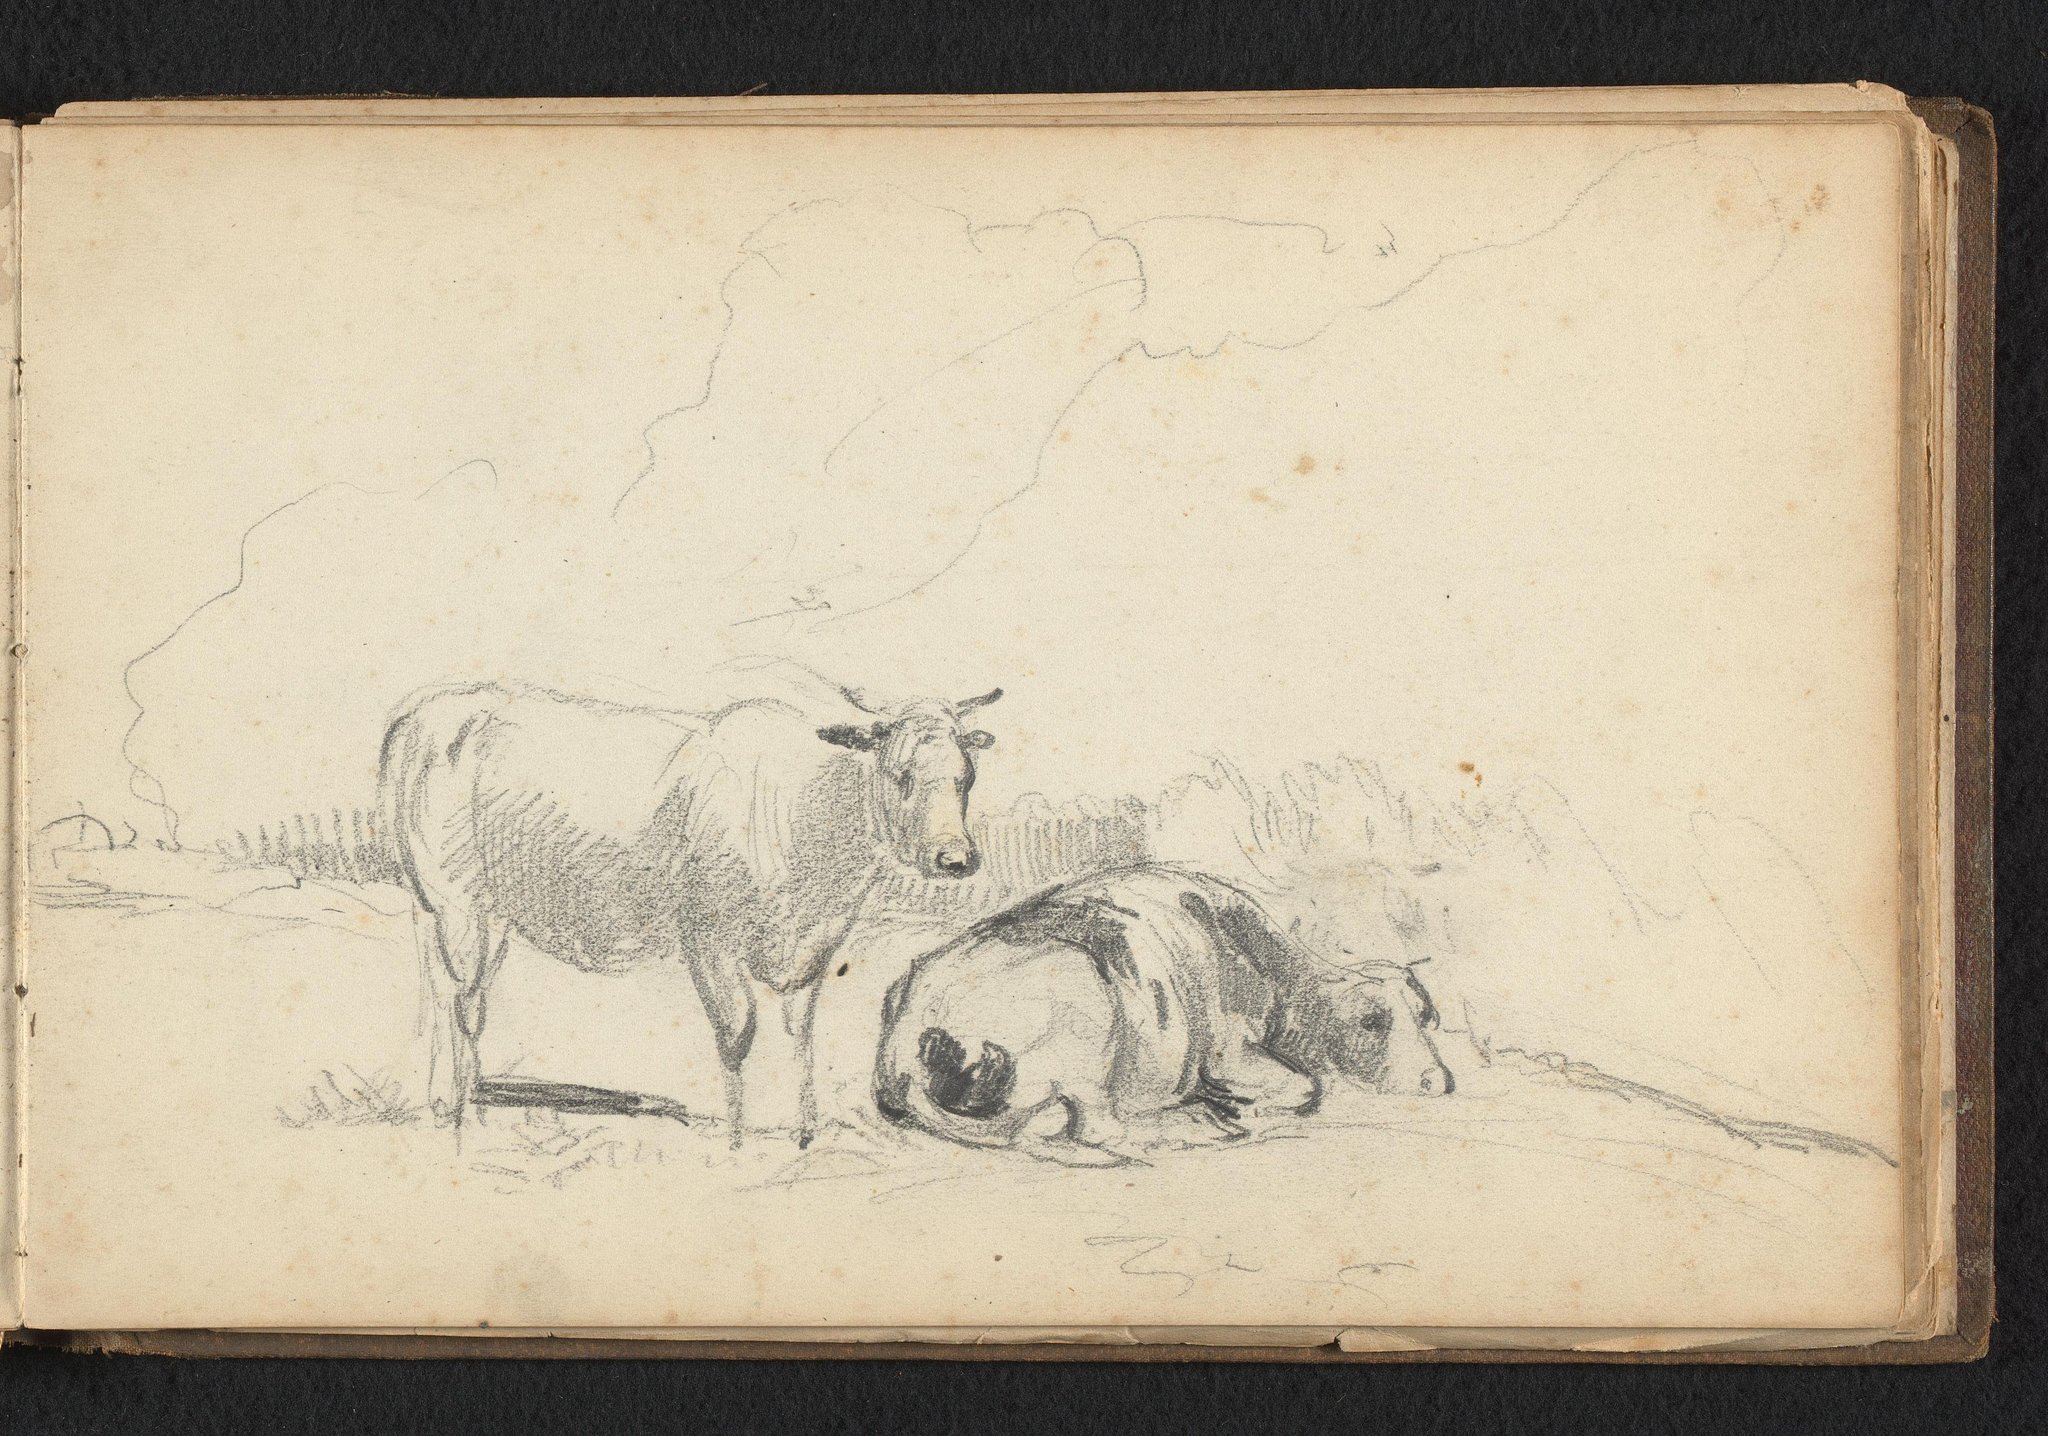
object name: sketchbook leaf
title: Twee koeien in een weide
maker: jan bedijs tom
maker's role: draughtsman, painter, print maker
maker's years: 1813-1894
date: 1823-1894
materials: paper, pencil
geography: the hague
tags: cow, meadow, pasture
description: Pagina 20 verso uit een schetsboek met 37 bladen.